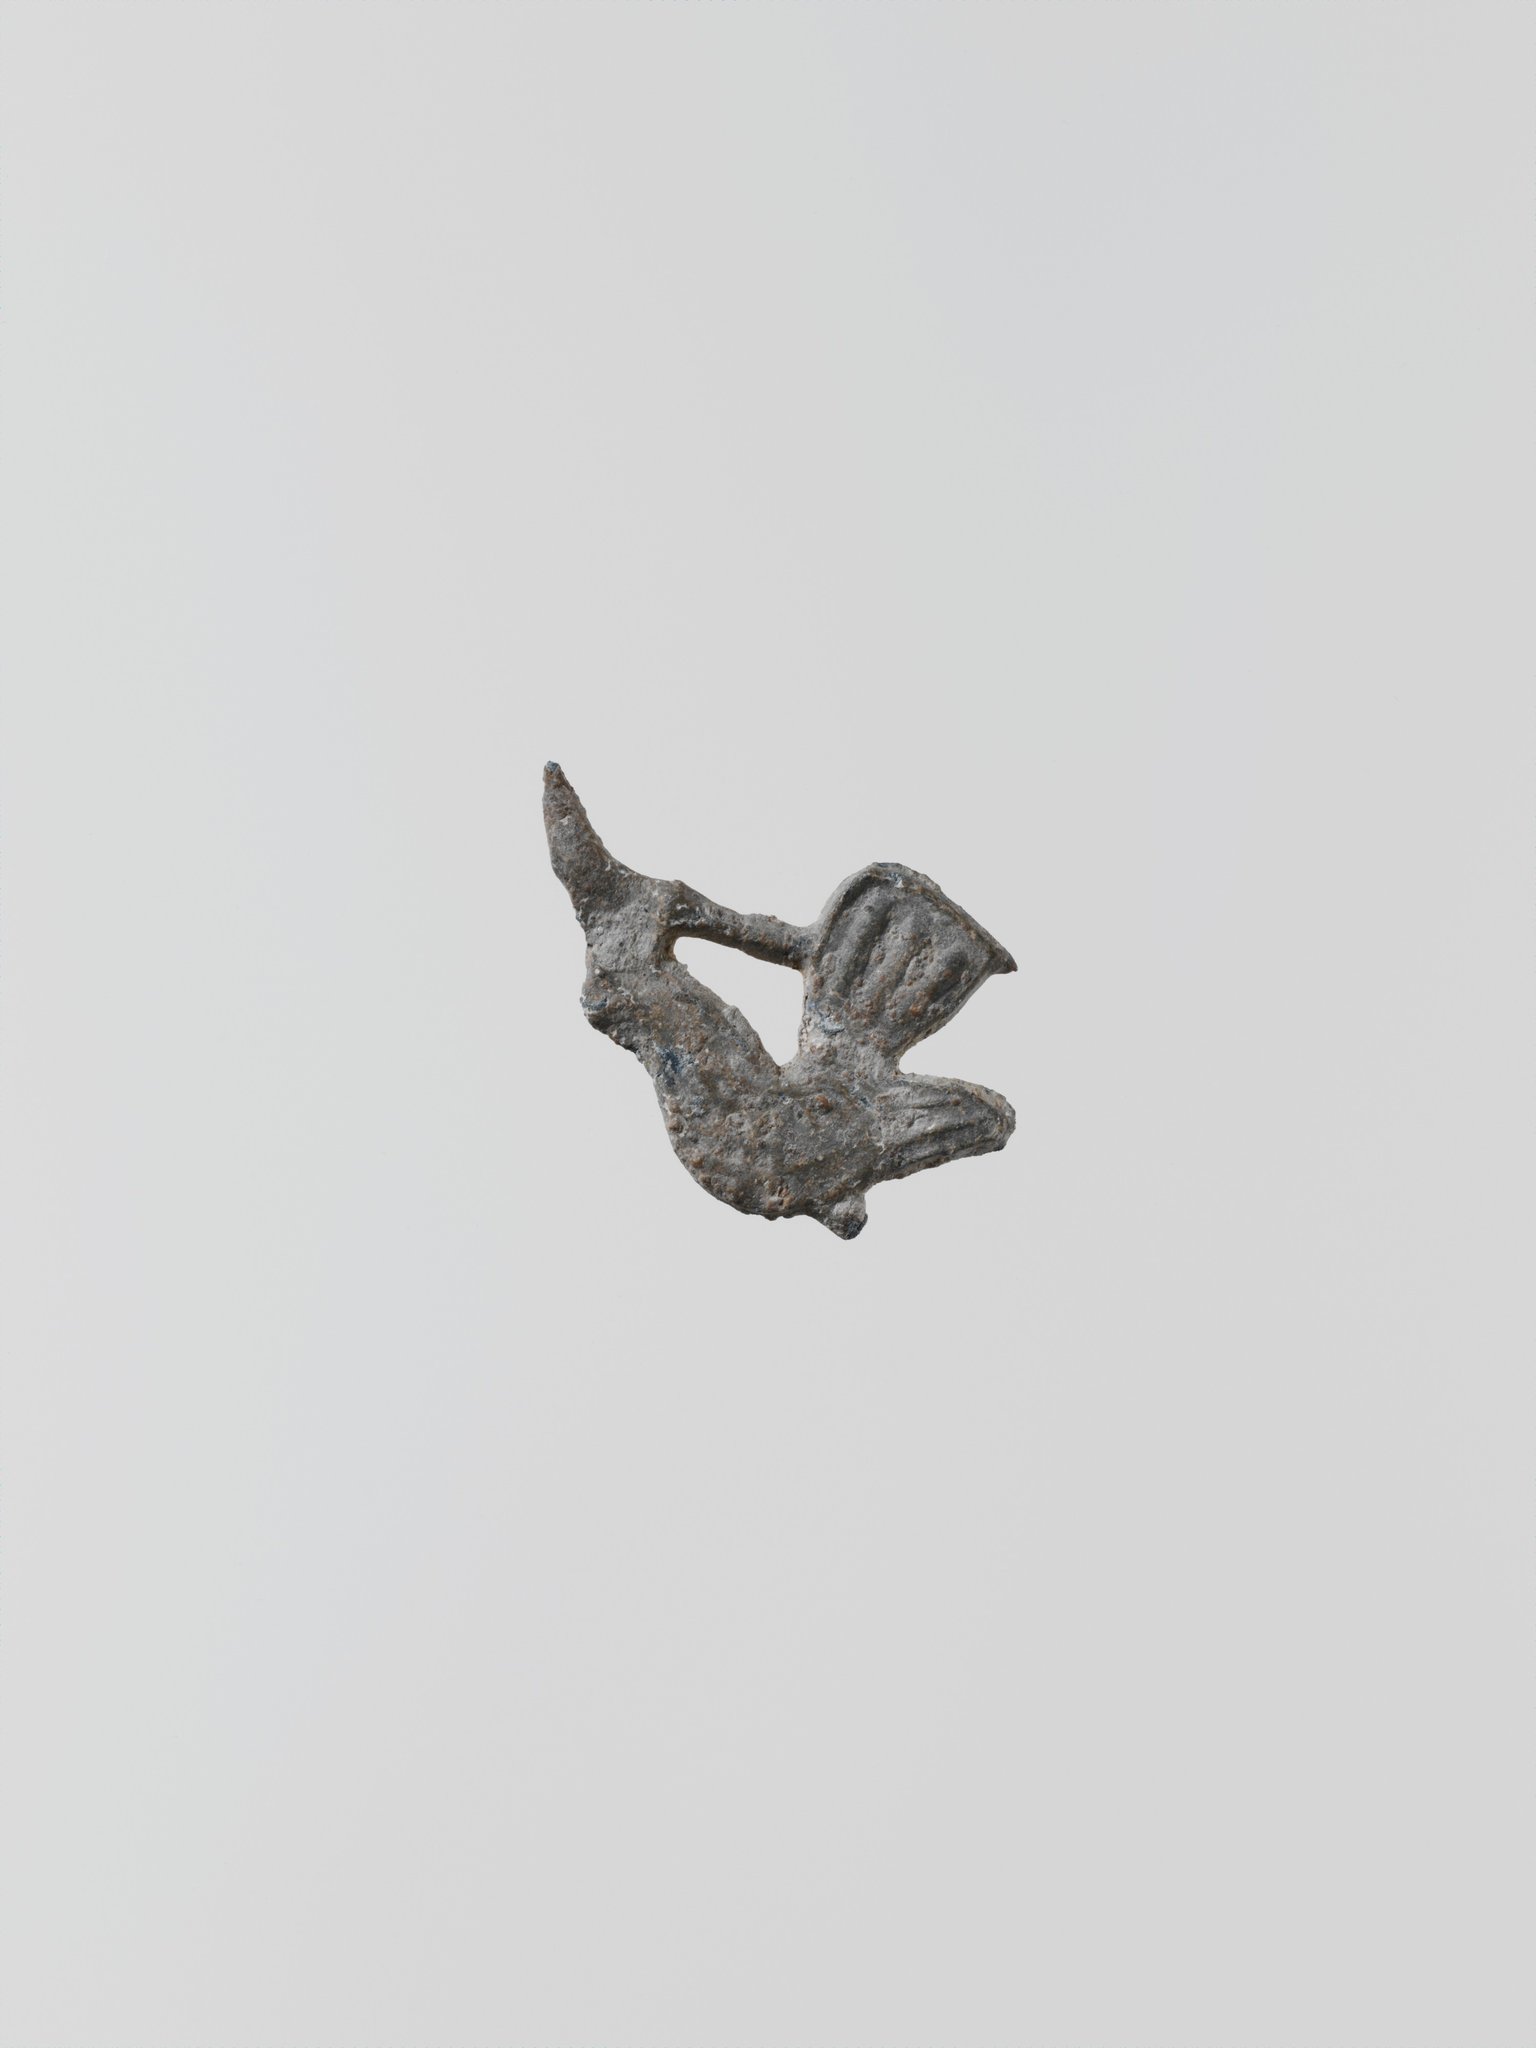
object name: statuette of a cock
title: Statuette of a cock, 2?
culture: greek, laconian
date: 7000-30 BCE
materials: lead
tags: roosters